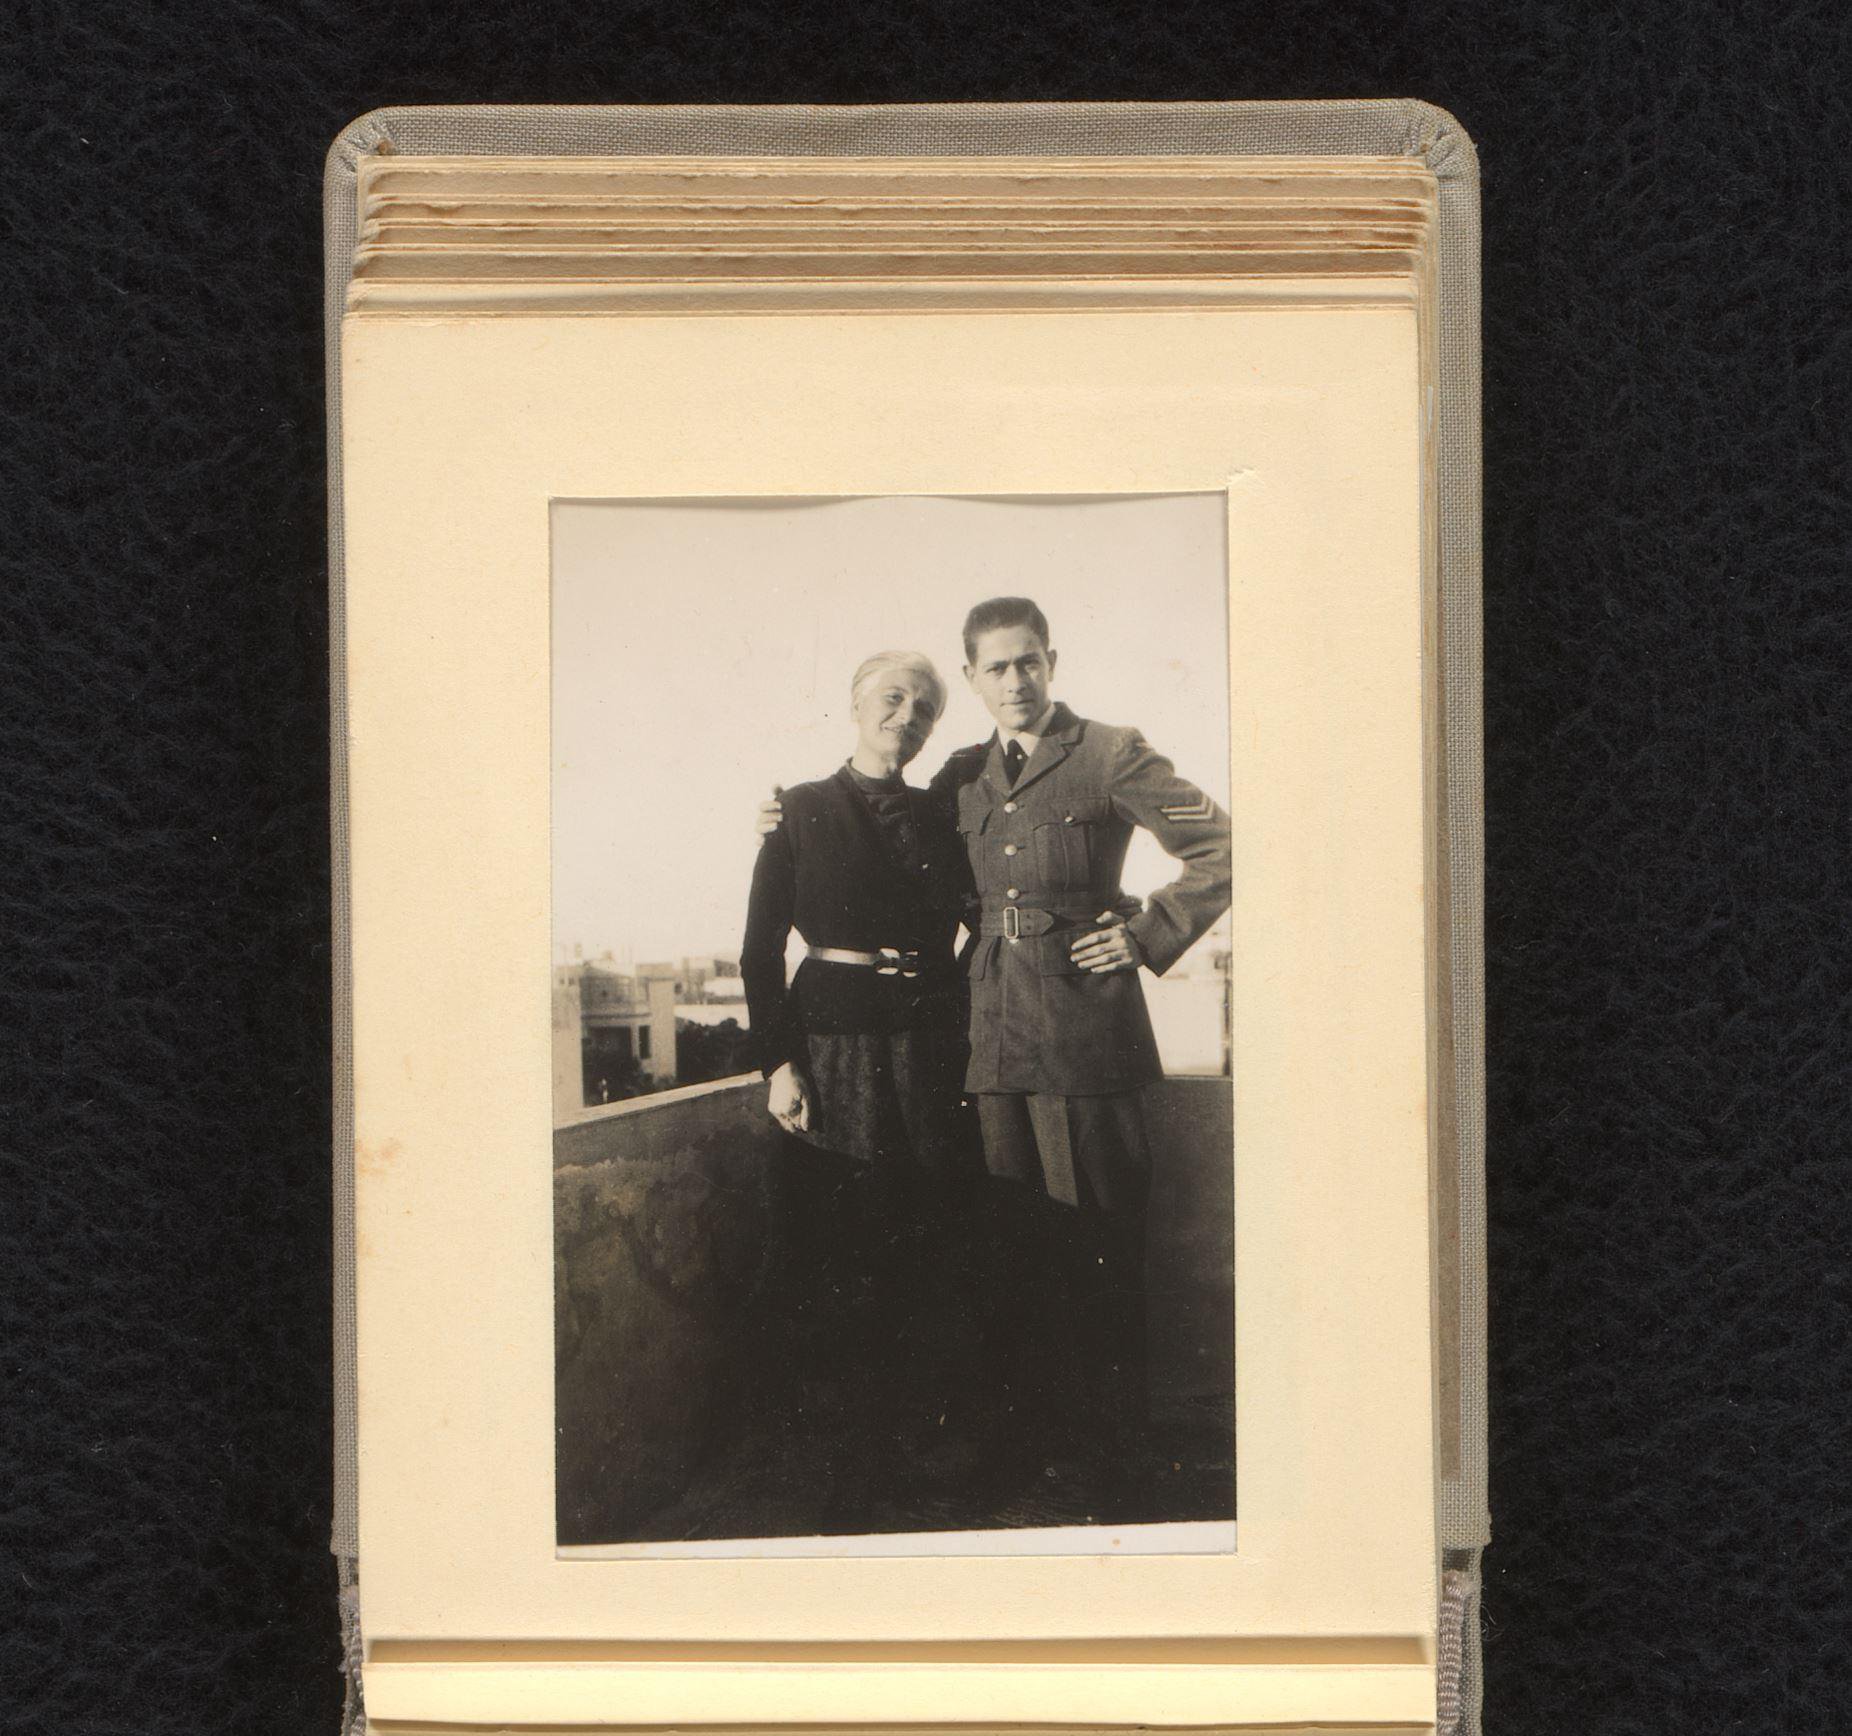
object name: album leaf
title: Klaus Zürndorfer in het uniform van de Britse Royal Air Force met zijn moeder Liesel Zürndorfer-Wachenheimer, 25 janauri 1943, Palestina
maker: isabel wachenheimer-elon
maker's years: 1928-2010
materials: paper, photographic support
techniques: gelatin silver print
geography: palestine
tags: historical persons - bb - woman, historical persons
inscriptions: date: ‘25/1/43’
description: Albumblad bevat een foto van Liesel Zürndorfer-Wachenheimer (links) en Klaus Zürndorfer (rechts). Onderdeel van het fotoalbum met diverse foto's van de jeugd van Isabel Wachenheimer voor en tijdens de oorlog en diverse momenten van haar volwassen leven na de Tweede Wereldoorlog.